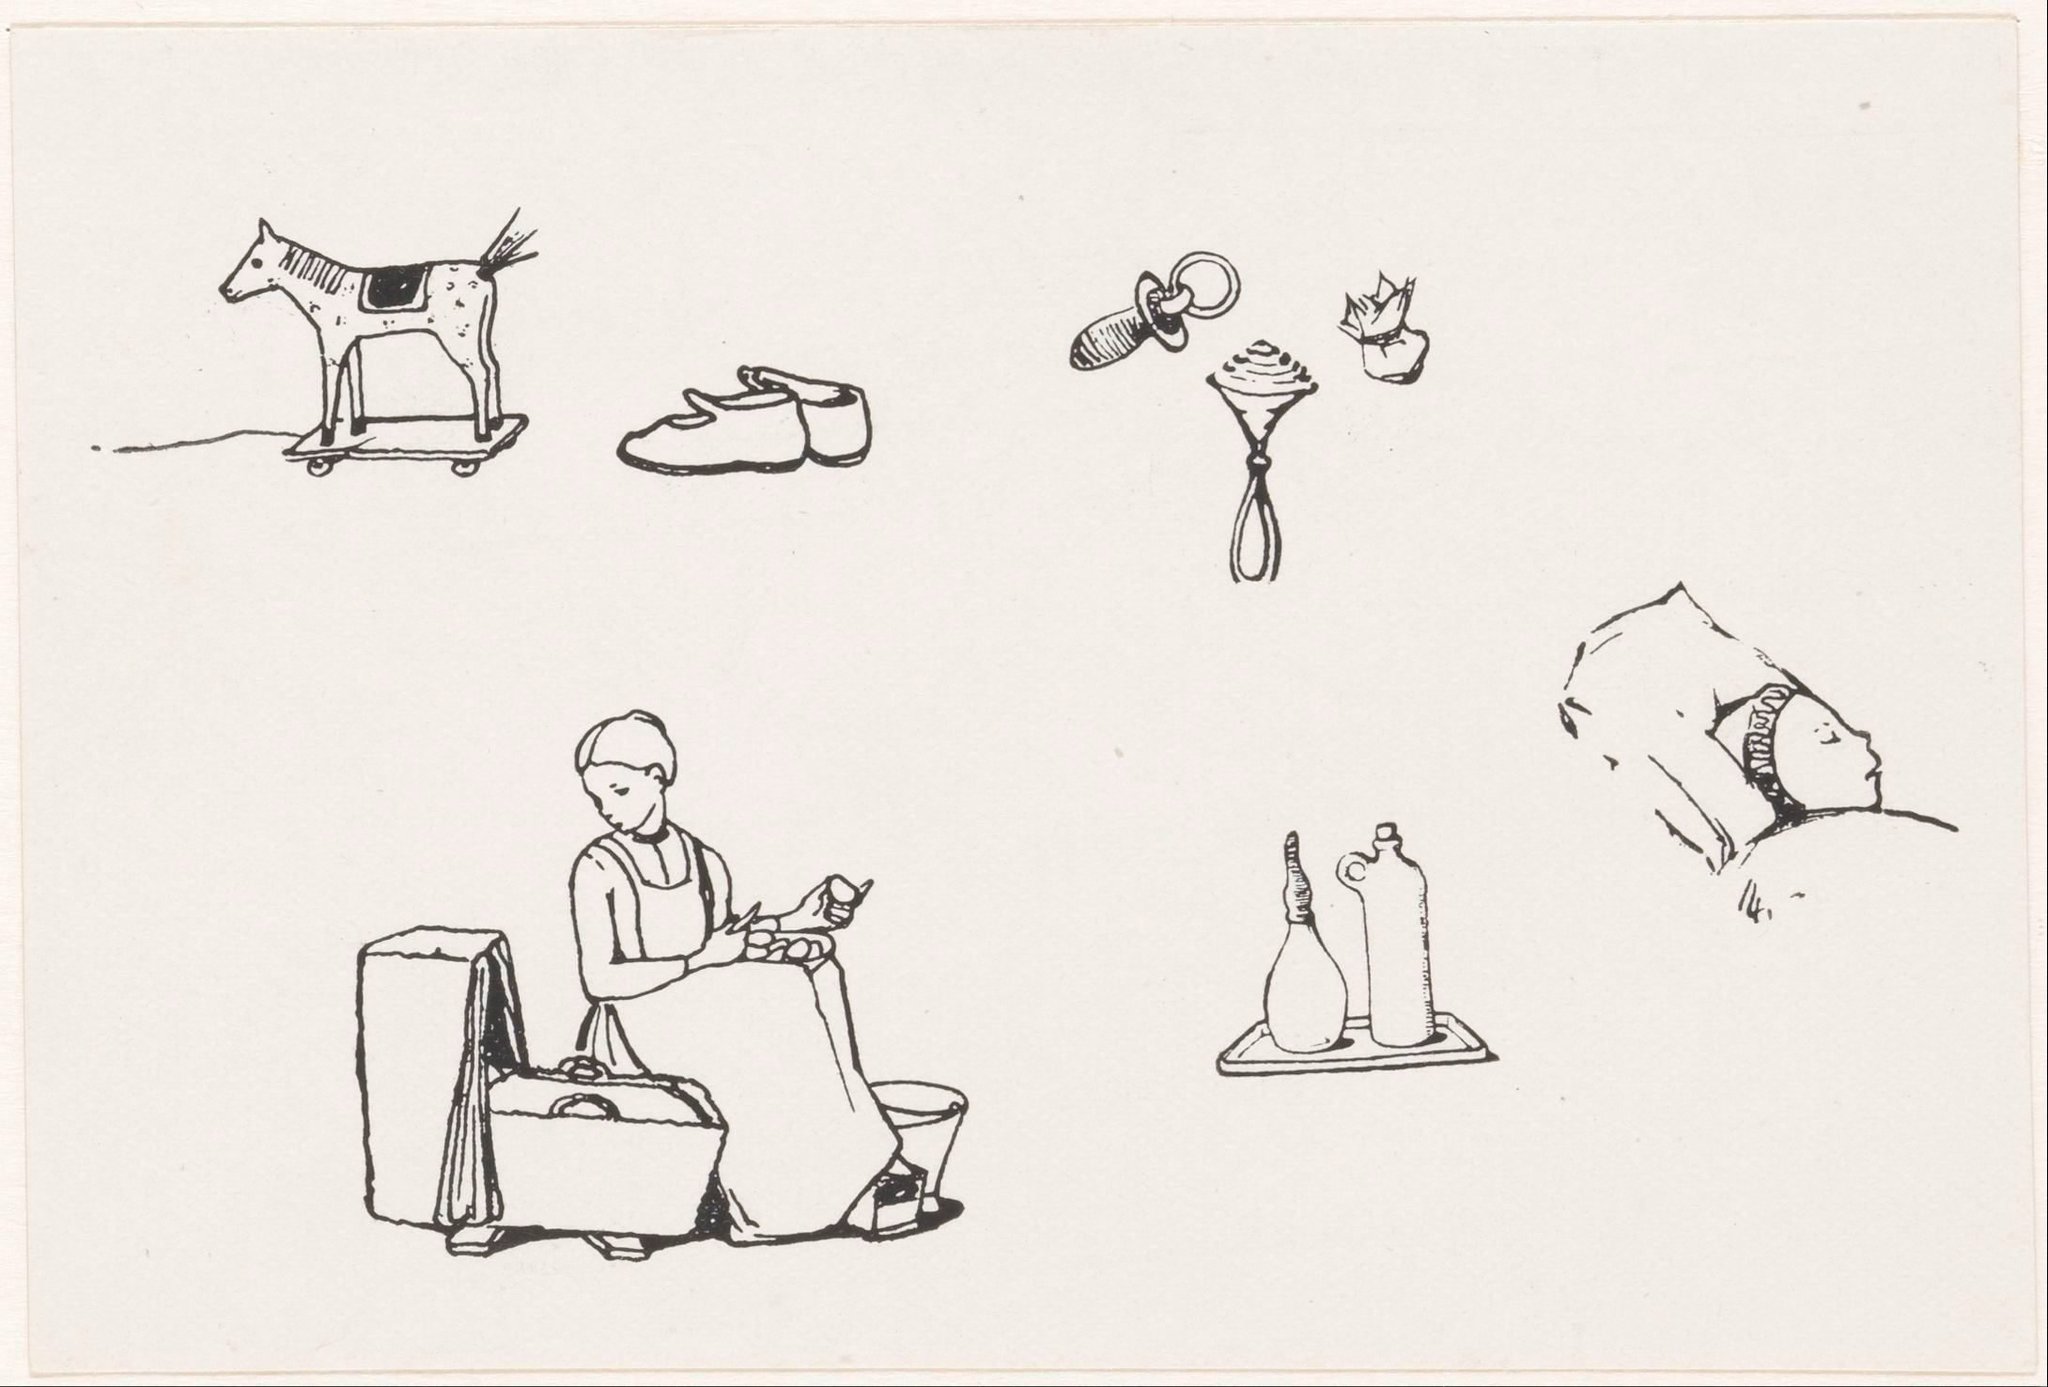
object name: print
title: Zes voorstellingen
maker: julie de graag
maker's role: draughtsman, print maker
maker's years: 1877-1924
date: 1878-1924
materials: paper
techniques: line block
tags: (playing with) toys, infant, baby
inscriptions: collector's mark: Lugt 2228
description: Van linksboven, met de klok mee: Een speelgoedpaard op een plank. Schoenen. Een speen, een rammelaar en een dichtgeknoopte zak. Een slapend kind. Een fles en een kruik op een dienblad. Een vrouw die aardappels schilt naast een wieg.